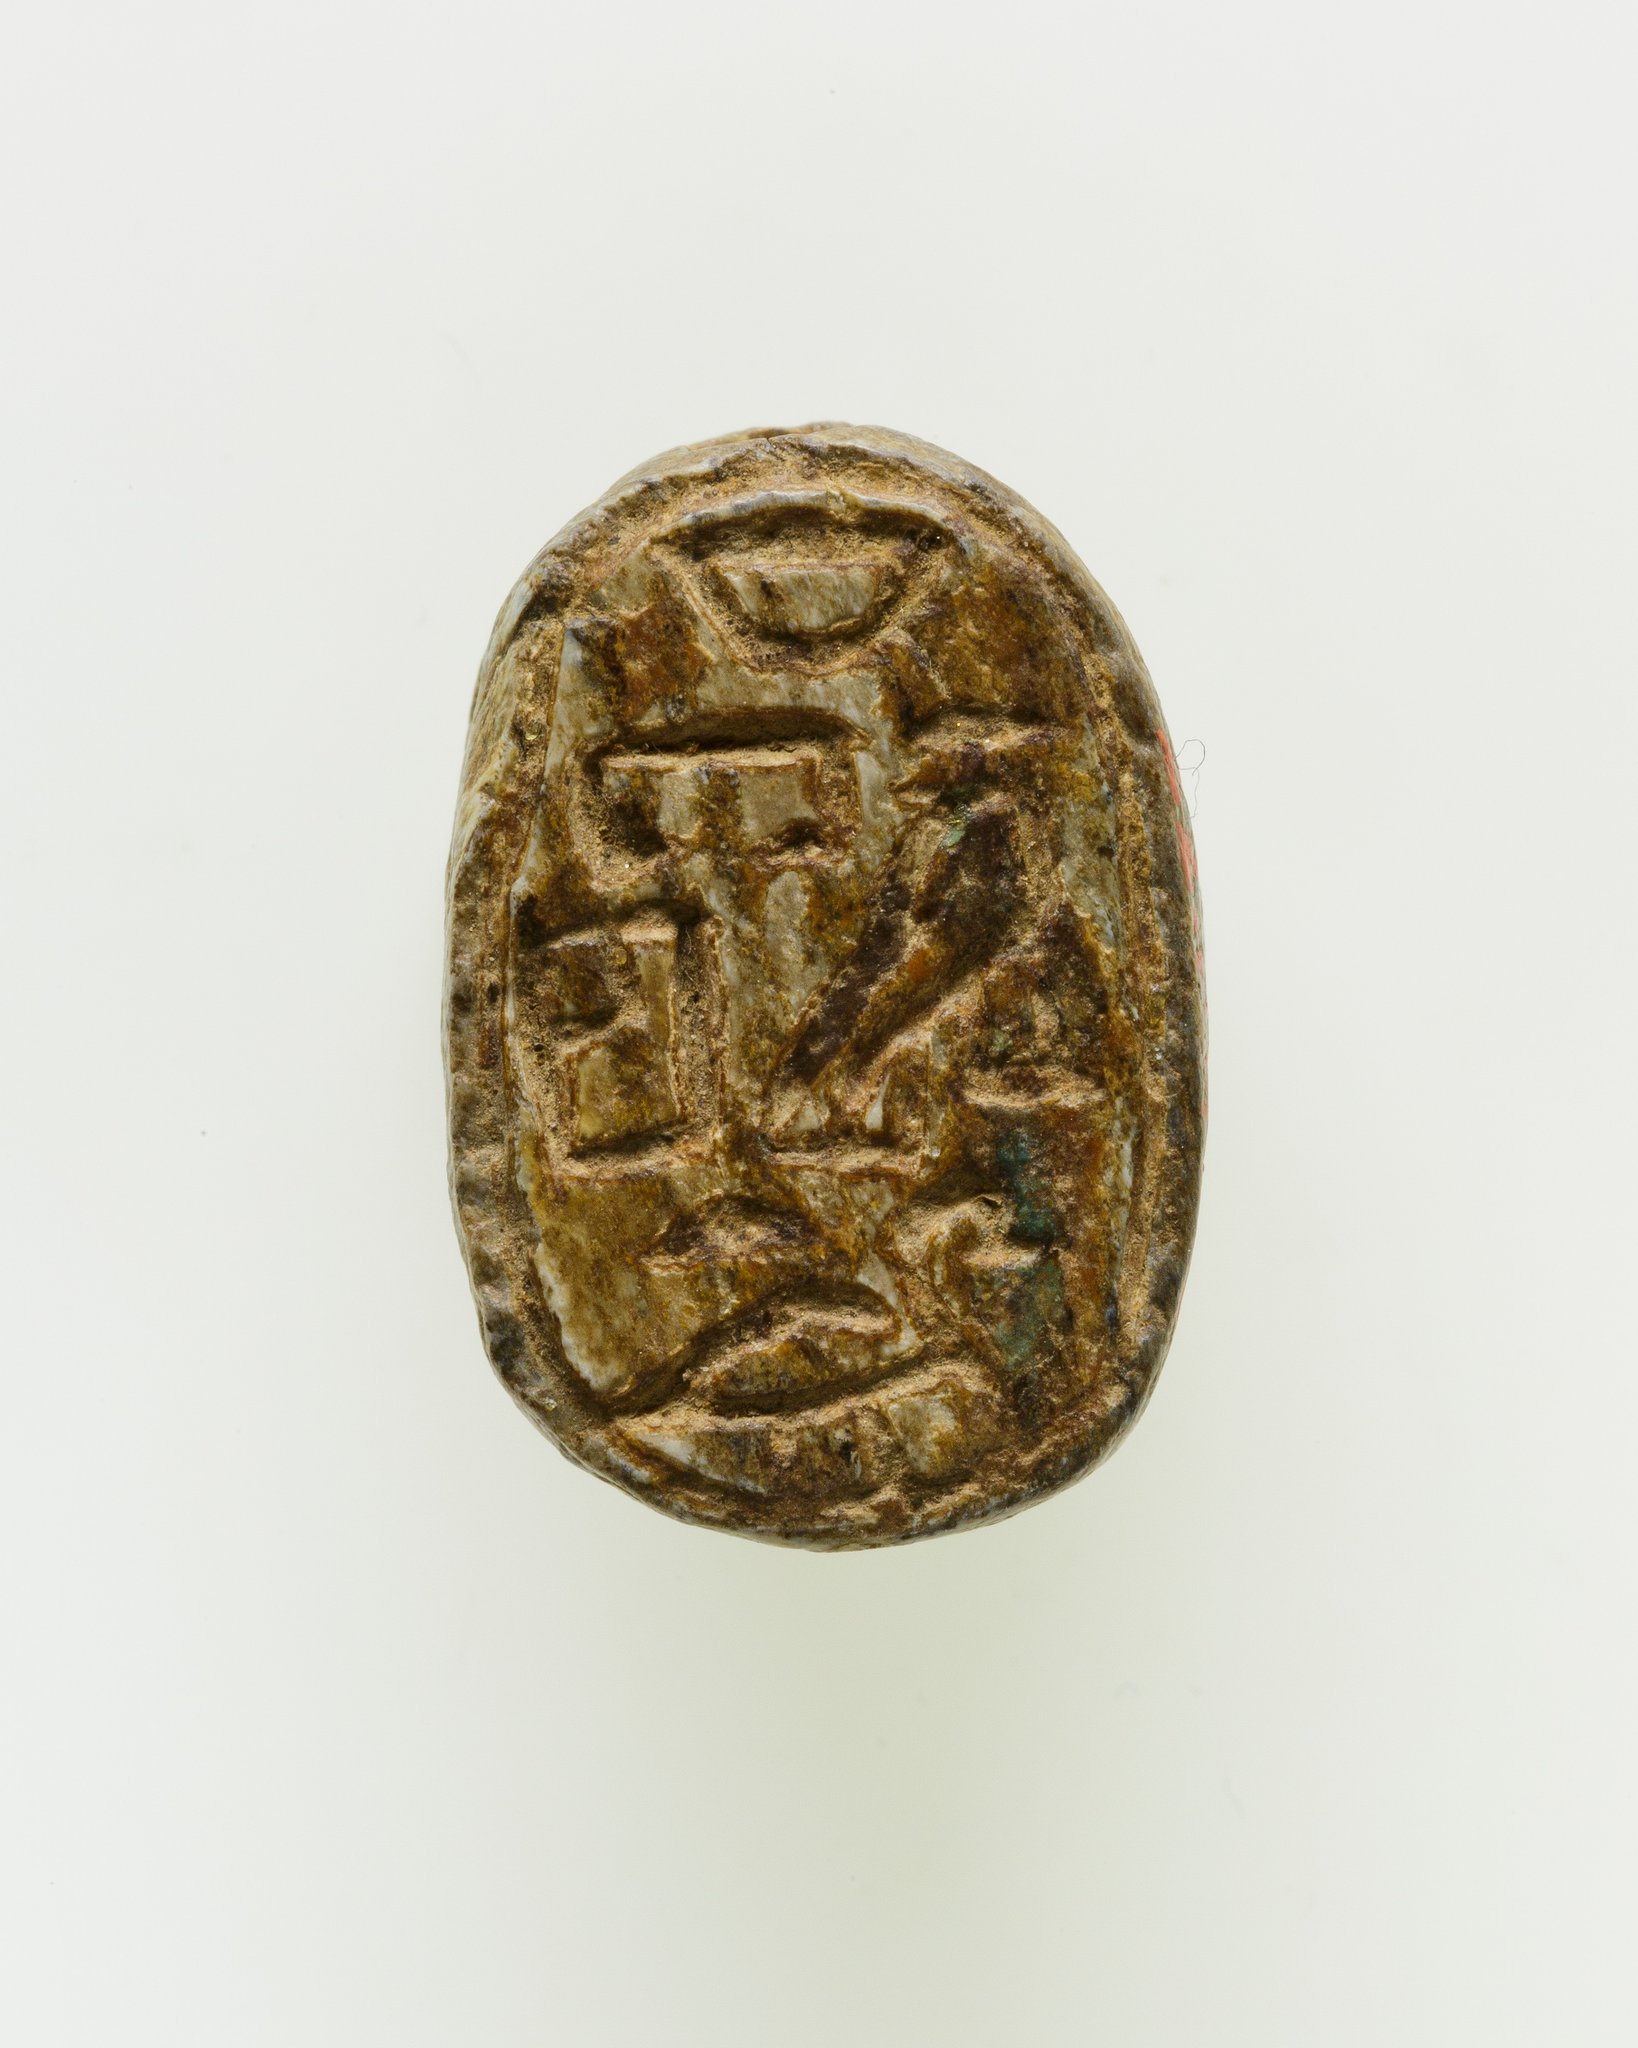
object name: scarab, private name and title, sathathor, lady of the house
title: Scarab of the Lady Sathathor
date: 1850-1640 BCE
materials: stone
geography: egypt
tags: hieroglyphs,scarabs